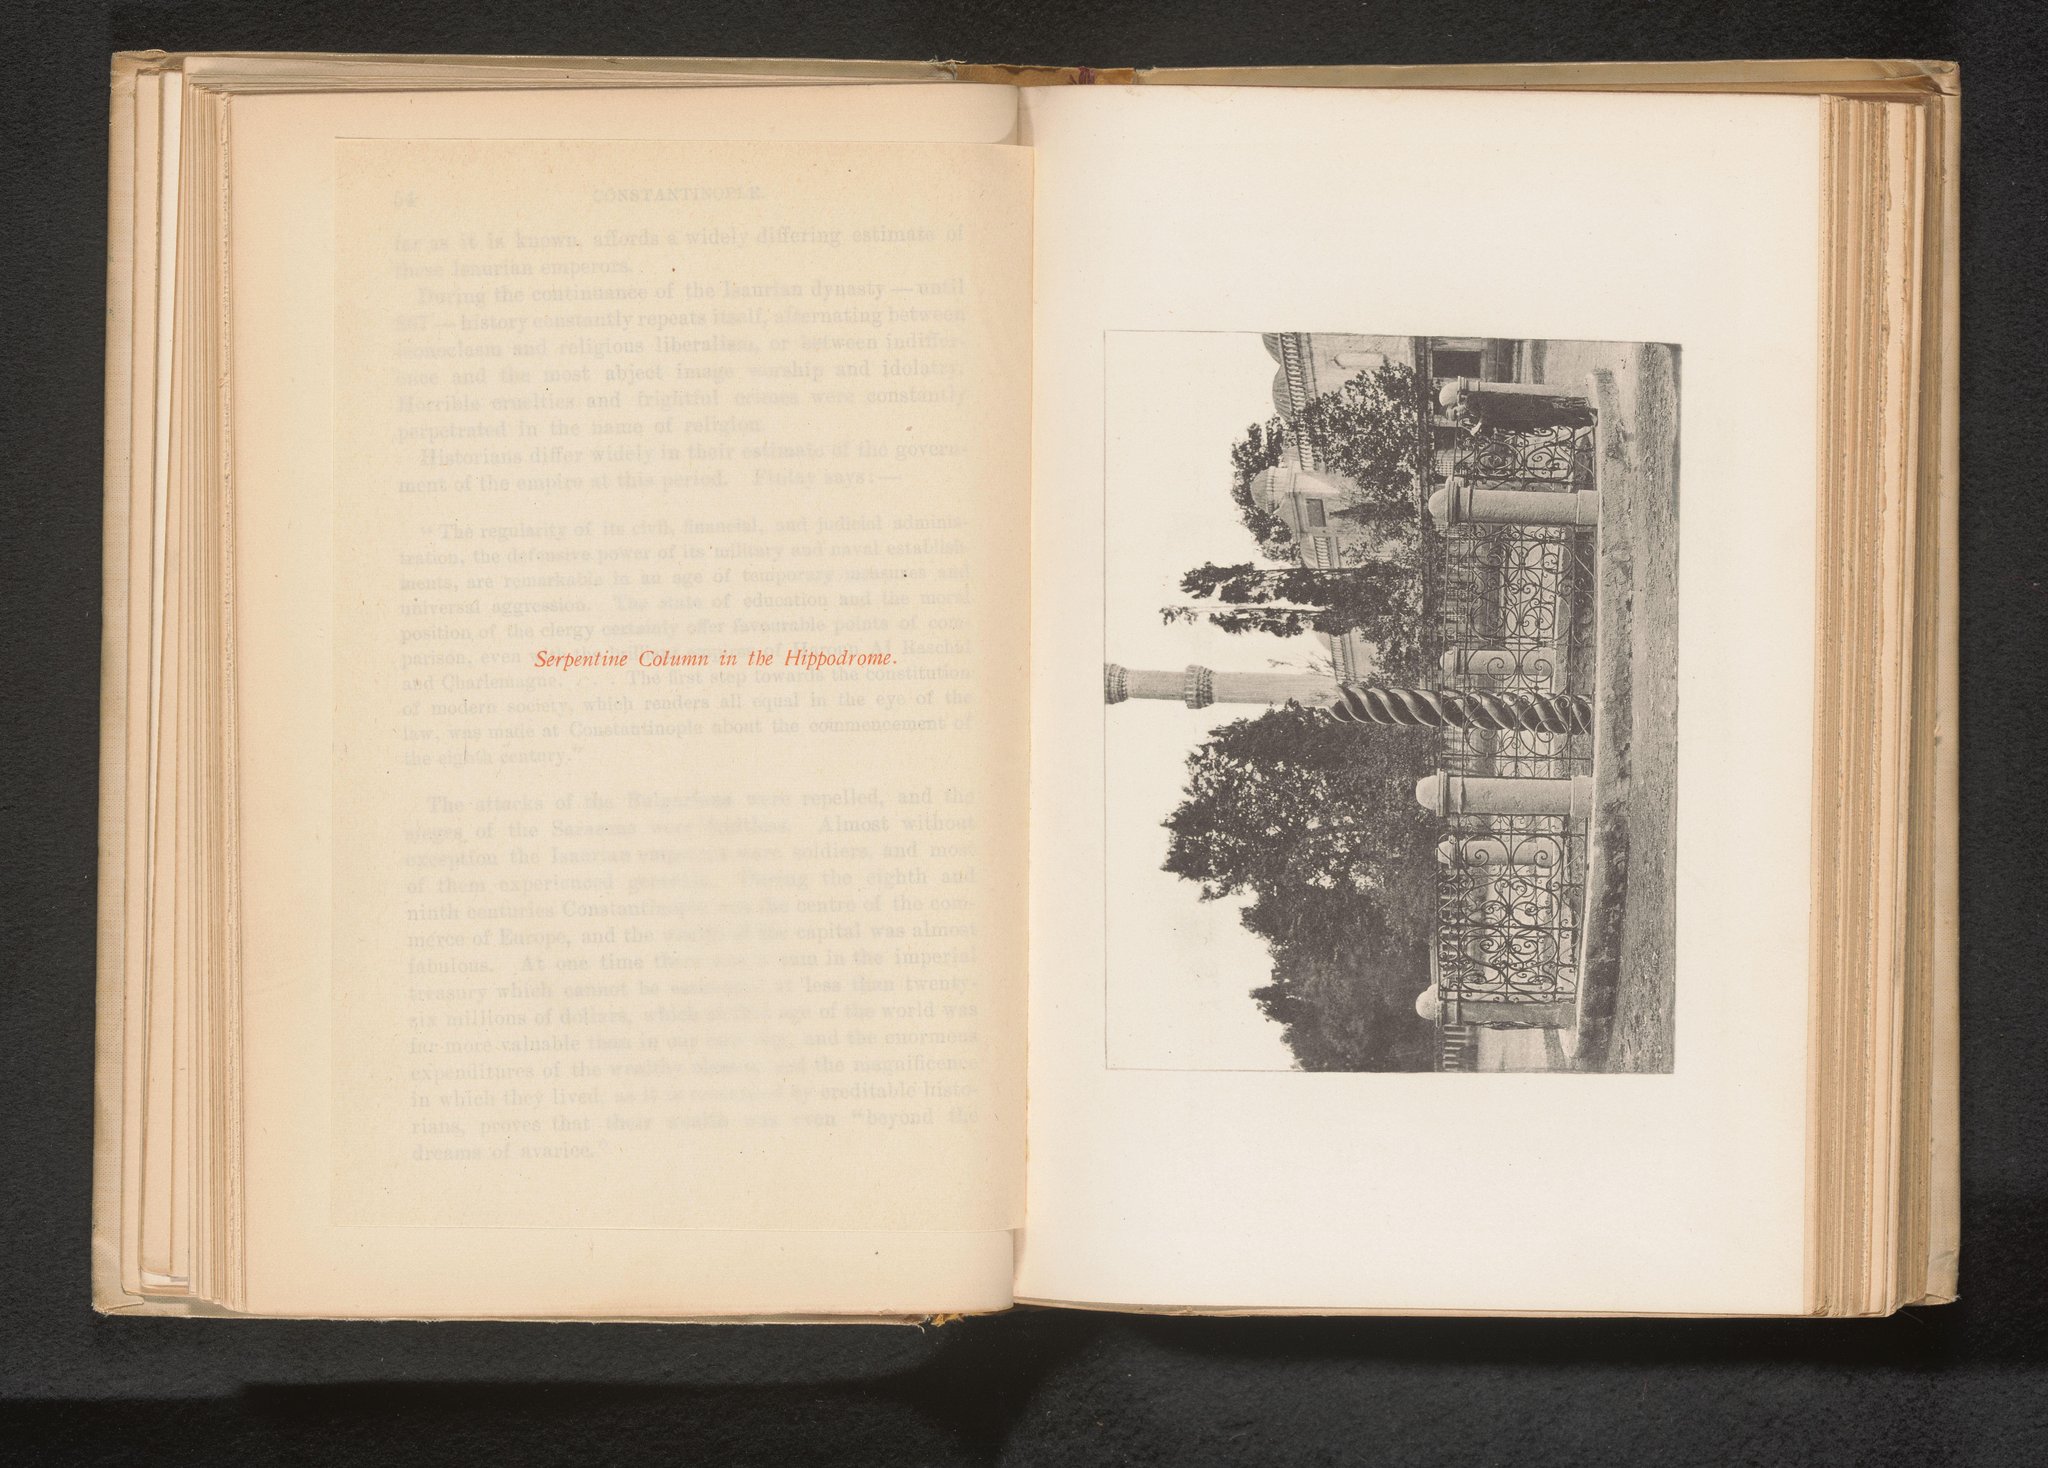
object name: photomechanical print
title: Slangenzuil te Constantinopel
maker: Anonymous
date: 1885-1895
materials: paper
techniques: photoaquatint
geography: constantinople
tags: column, pillar ~ architecture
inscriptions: title: ‘Serpentine Column in the Hippodrome.’